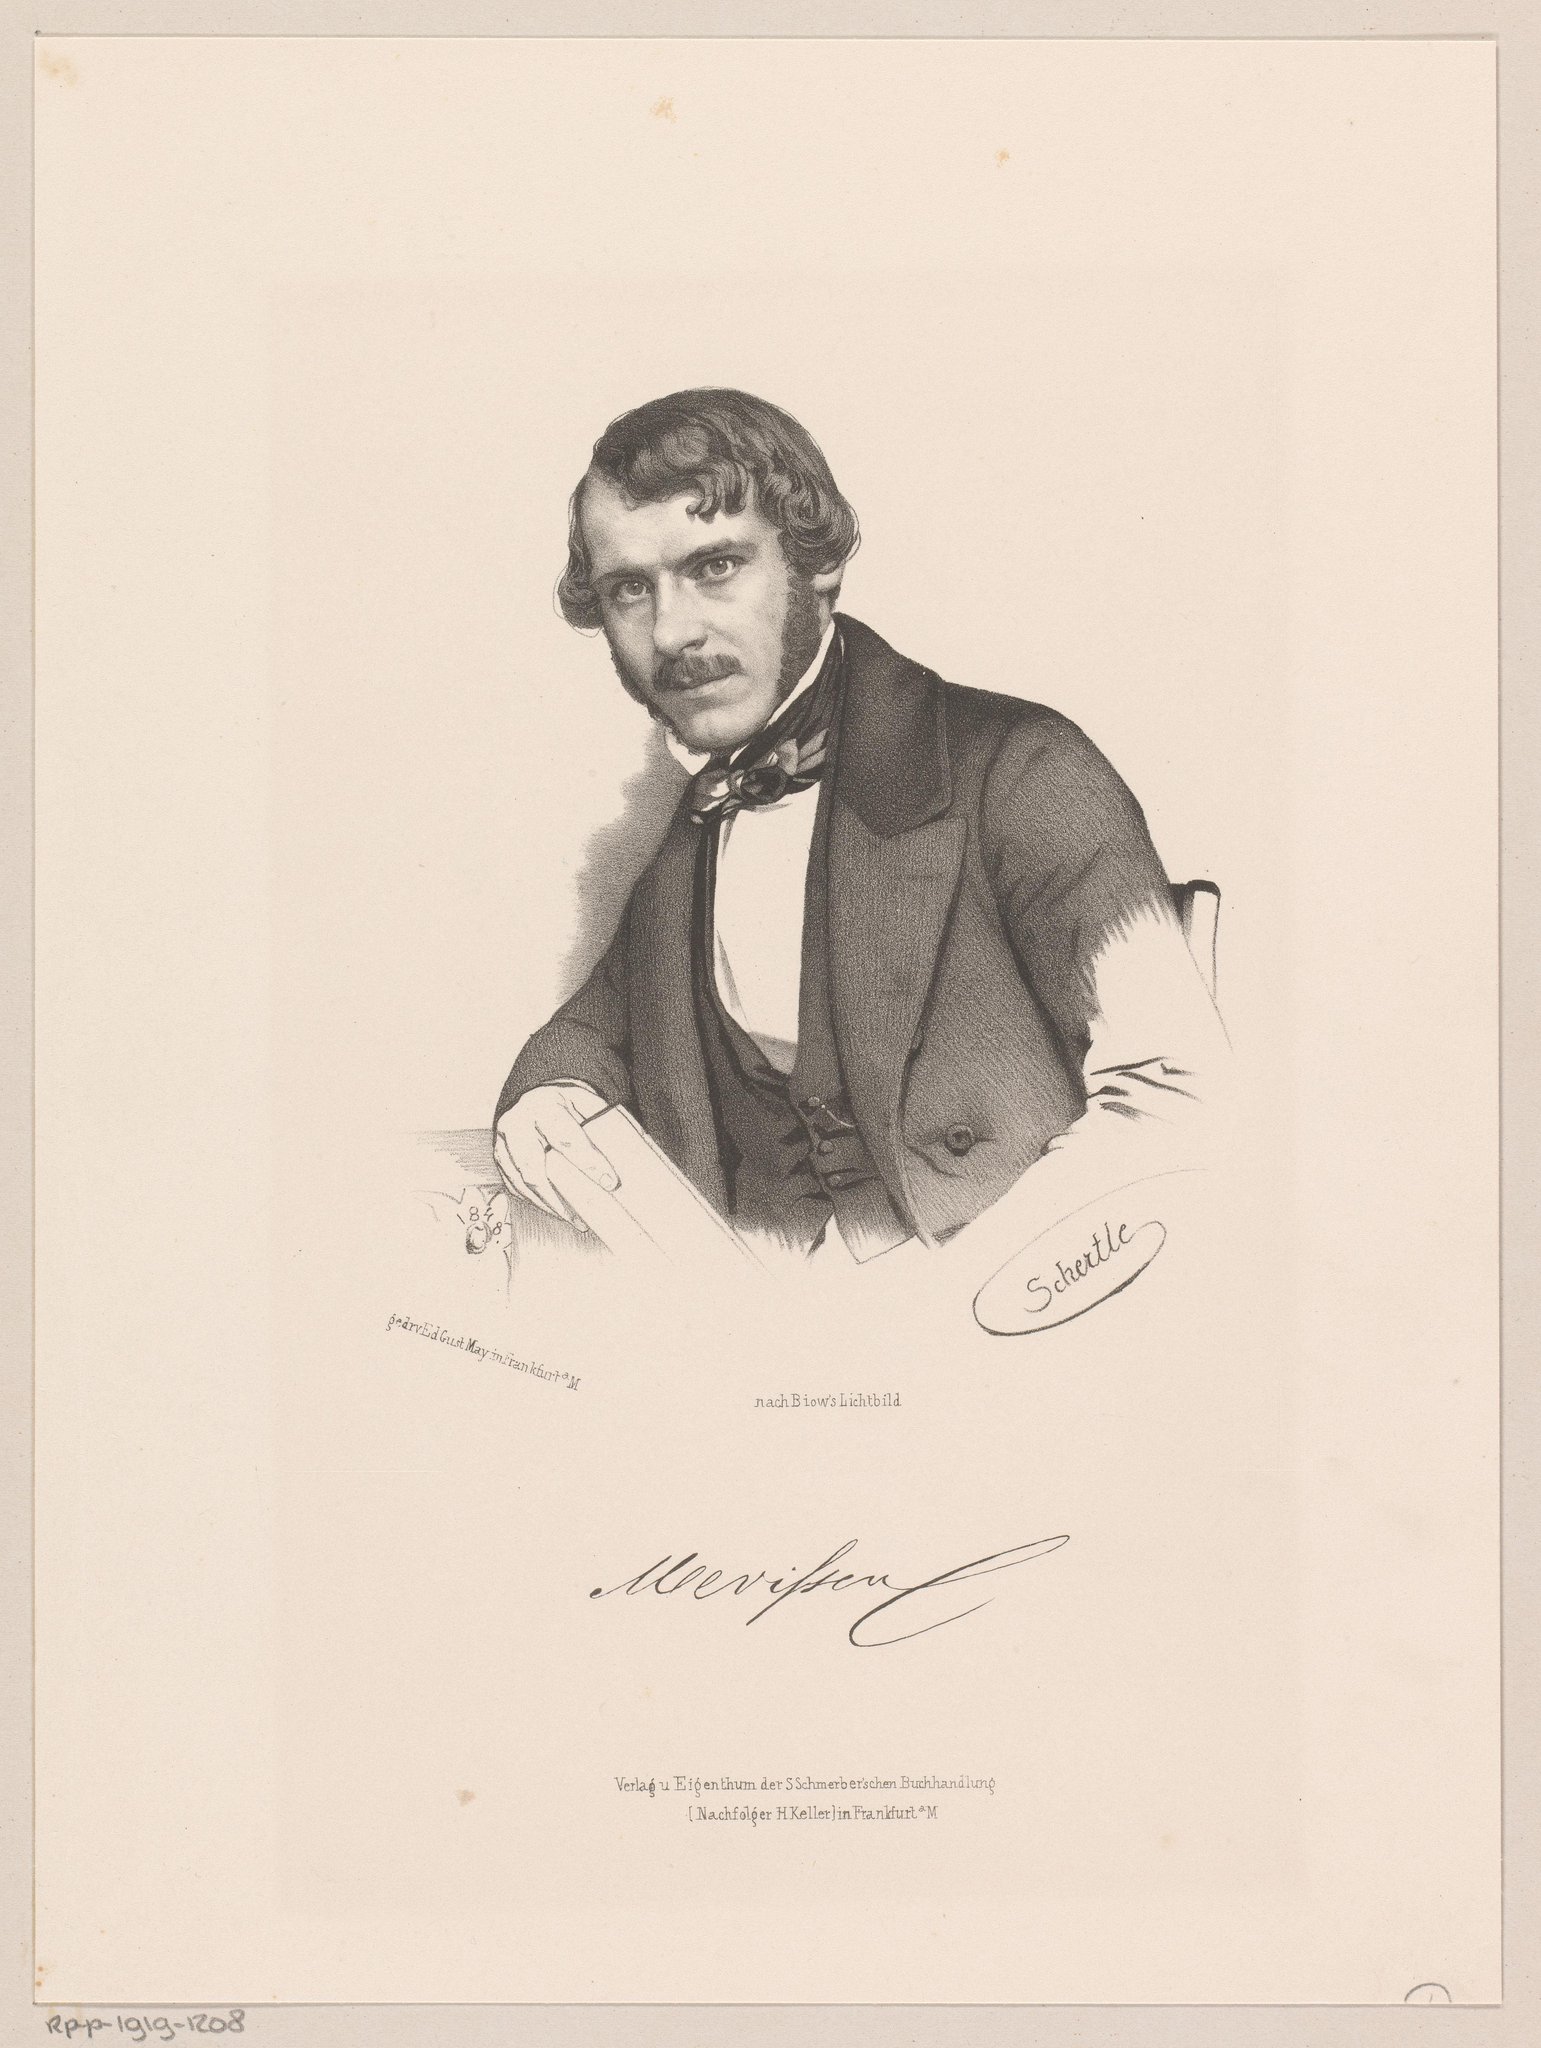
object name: print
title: Portretten van Duitse mannen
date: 1848-1849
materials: paper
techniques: lithograph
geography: frankfurt am main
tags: adult man, historical persons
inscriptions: collector's mark: Lugt 2228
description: Met facsimile signatuur van de geportretteerde.